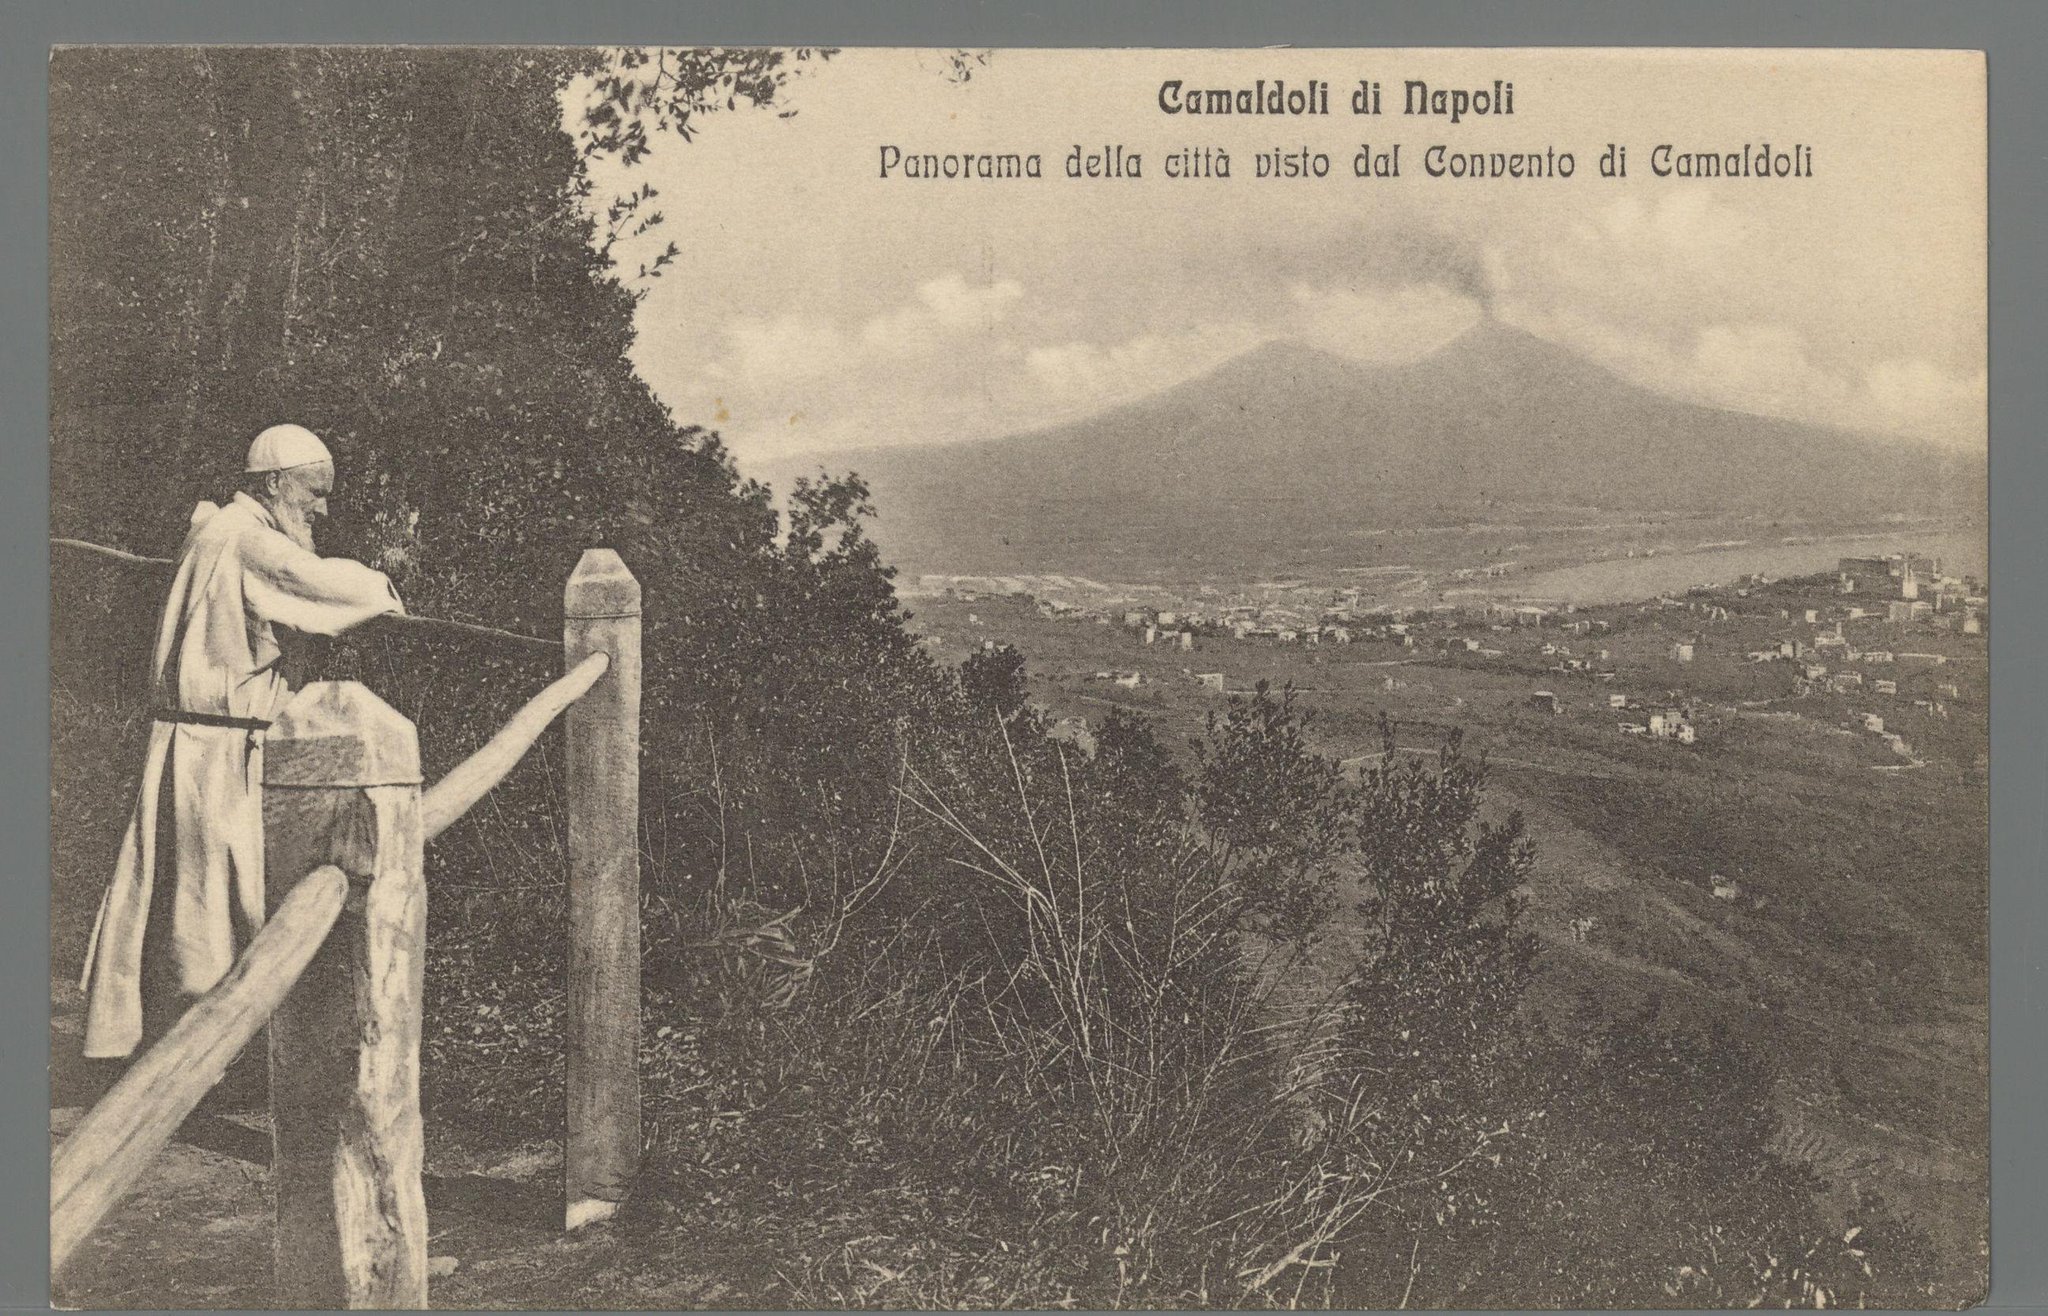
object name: photomechanical print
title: Camaldoli di Napoli. Panorama della città visto dal Convento di Camaldoli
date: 1906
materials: cardboard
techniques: photograph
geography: terni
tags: monk(s), friar(s), mountains (+ landscape with figures, staffage), eruption (of volcano), mount vesuvius, camaldoli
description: Een monnik kijkt uit over de Golf van Napels. Op de achtergrond een rokende Vesuvius.